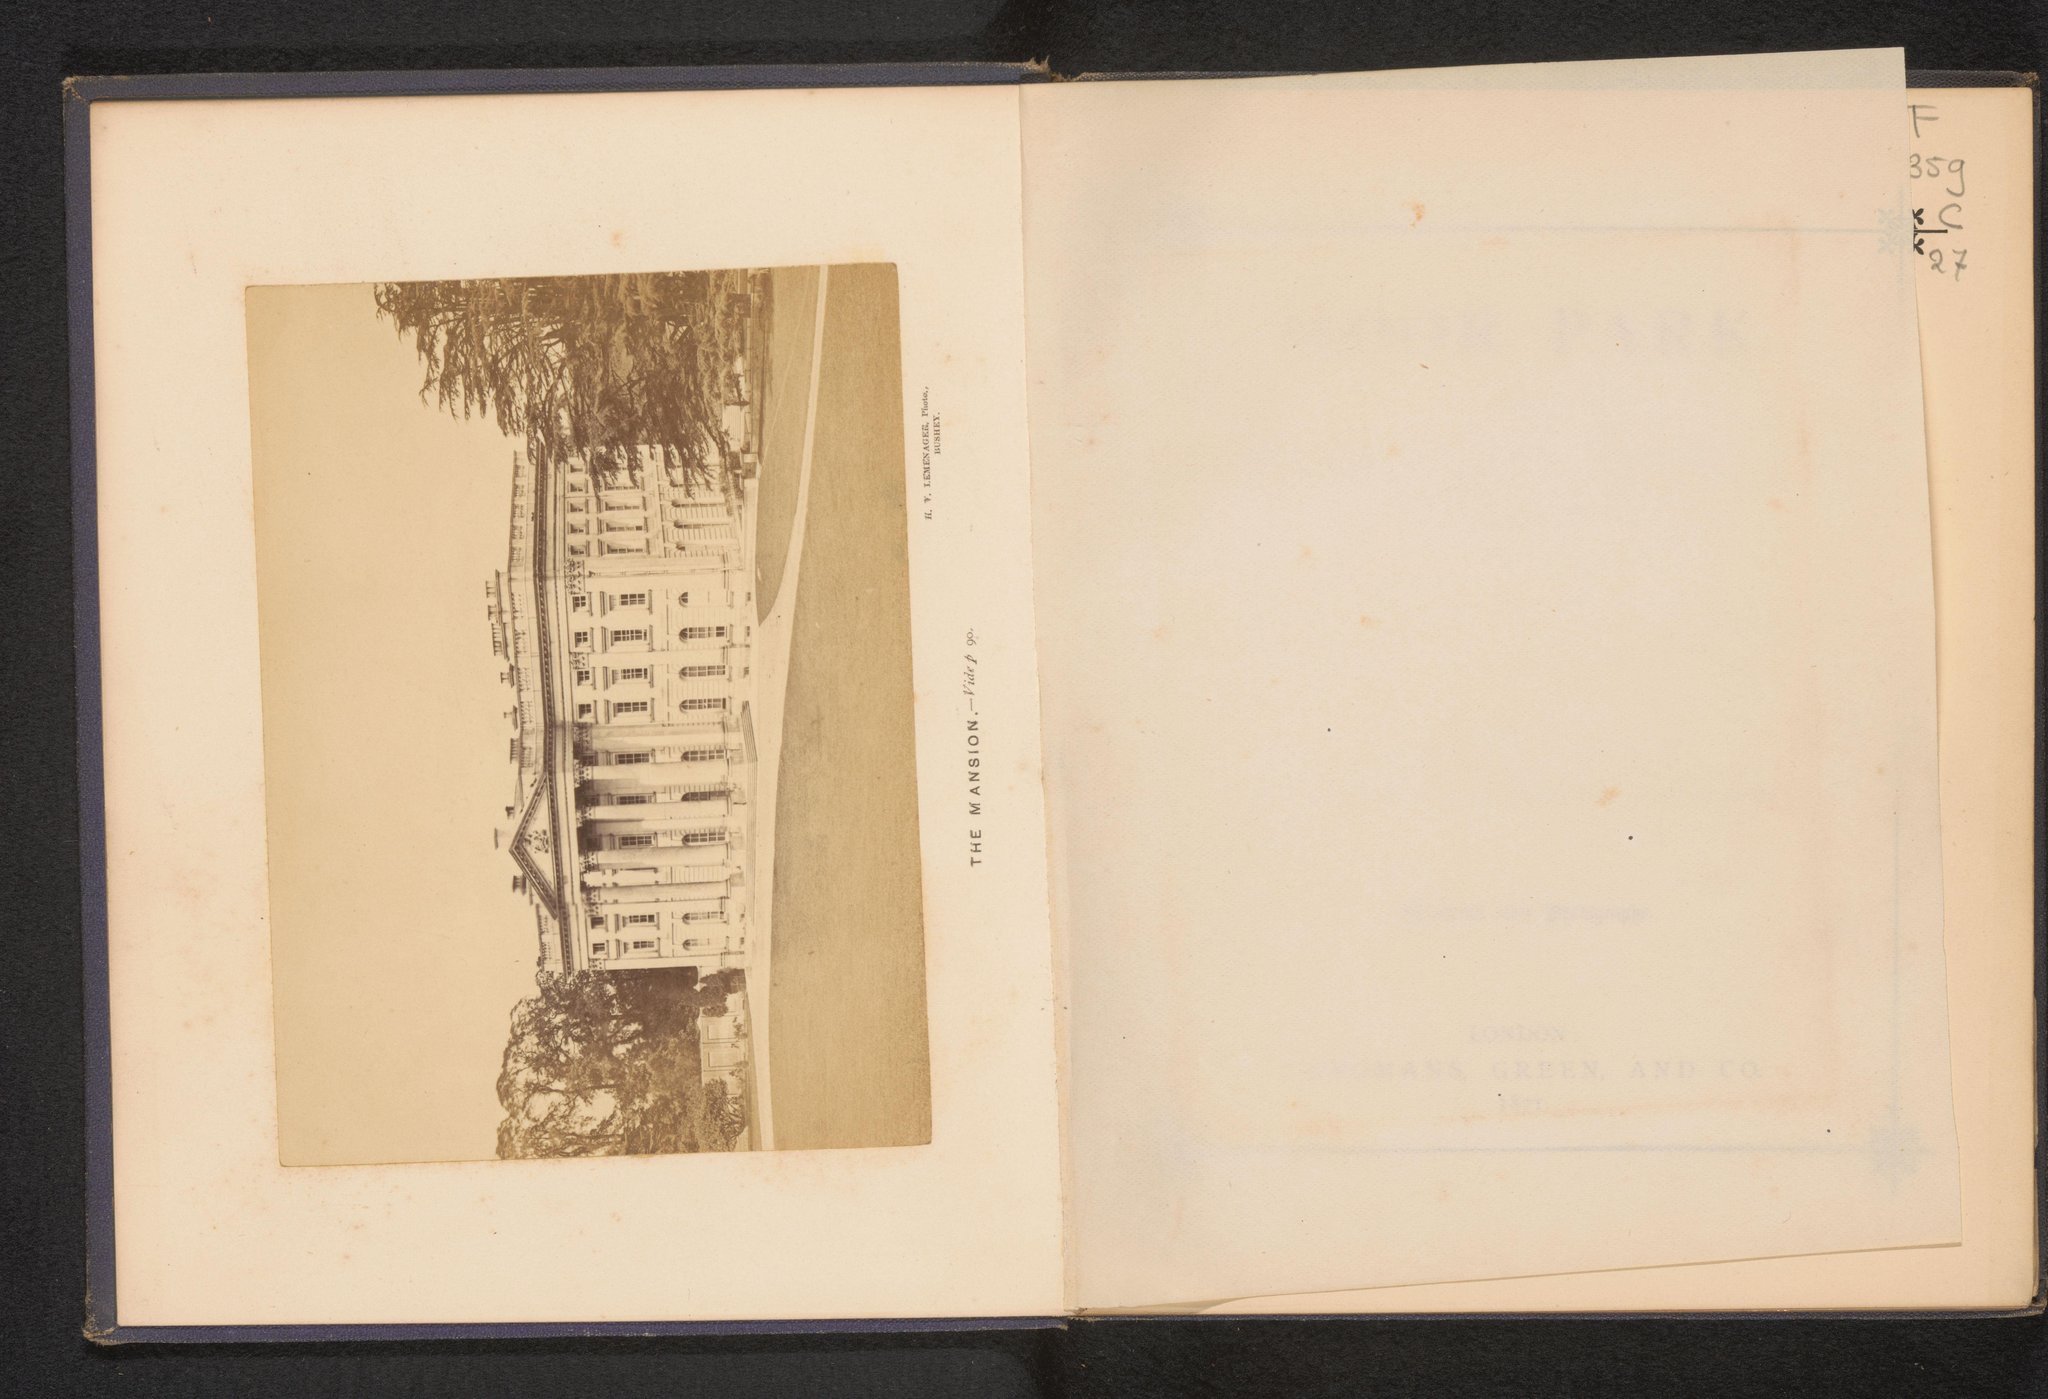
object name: page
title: Gezicht op Moor Park Mansion in Rickmansworth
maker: henri victor leménager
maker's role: docent, fotograaf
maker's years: 1822-1912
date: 1866-1871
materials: photographic support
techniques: albumen print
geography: rickmansworth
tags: villa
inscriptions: inscription: ‘Vide p 90.’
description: Foto tegenover titelpagina, achter semi-transparante omslag.